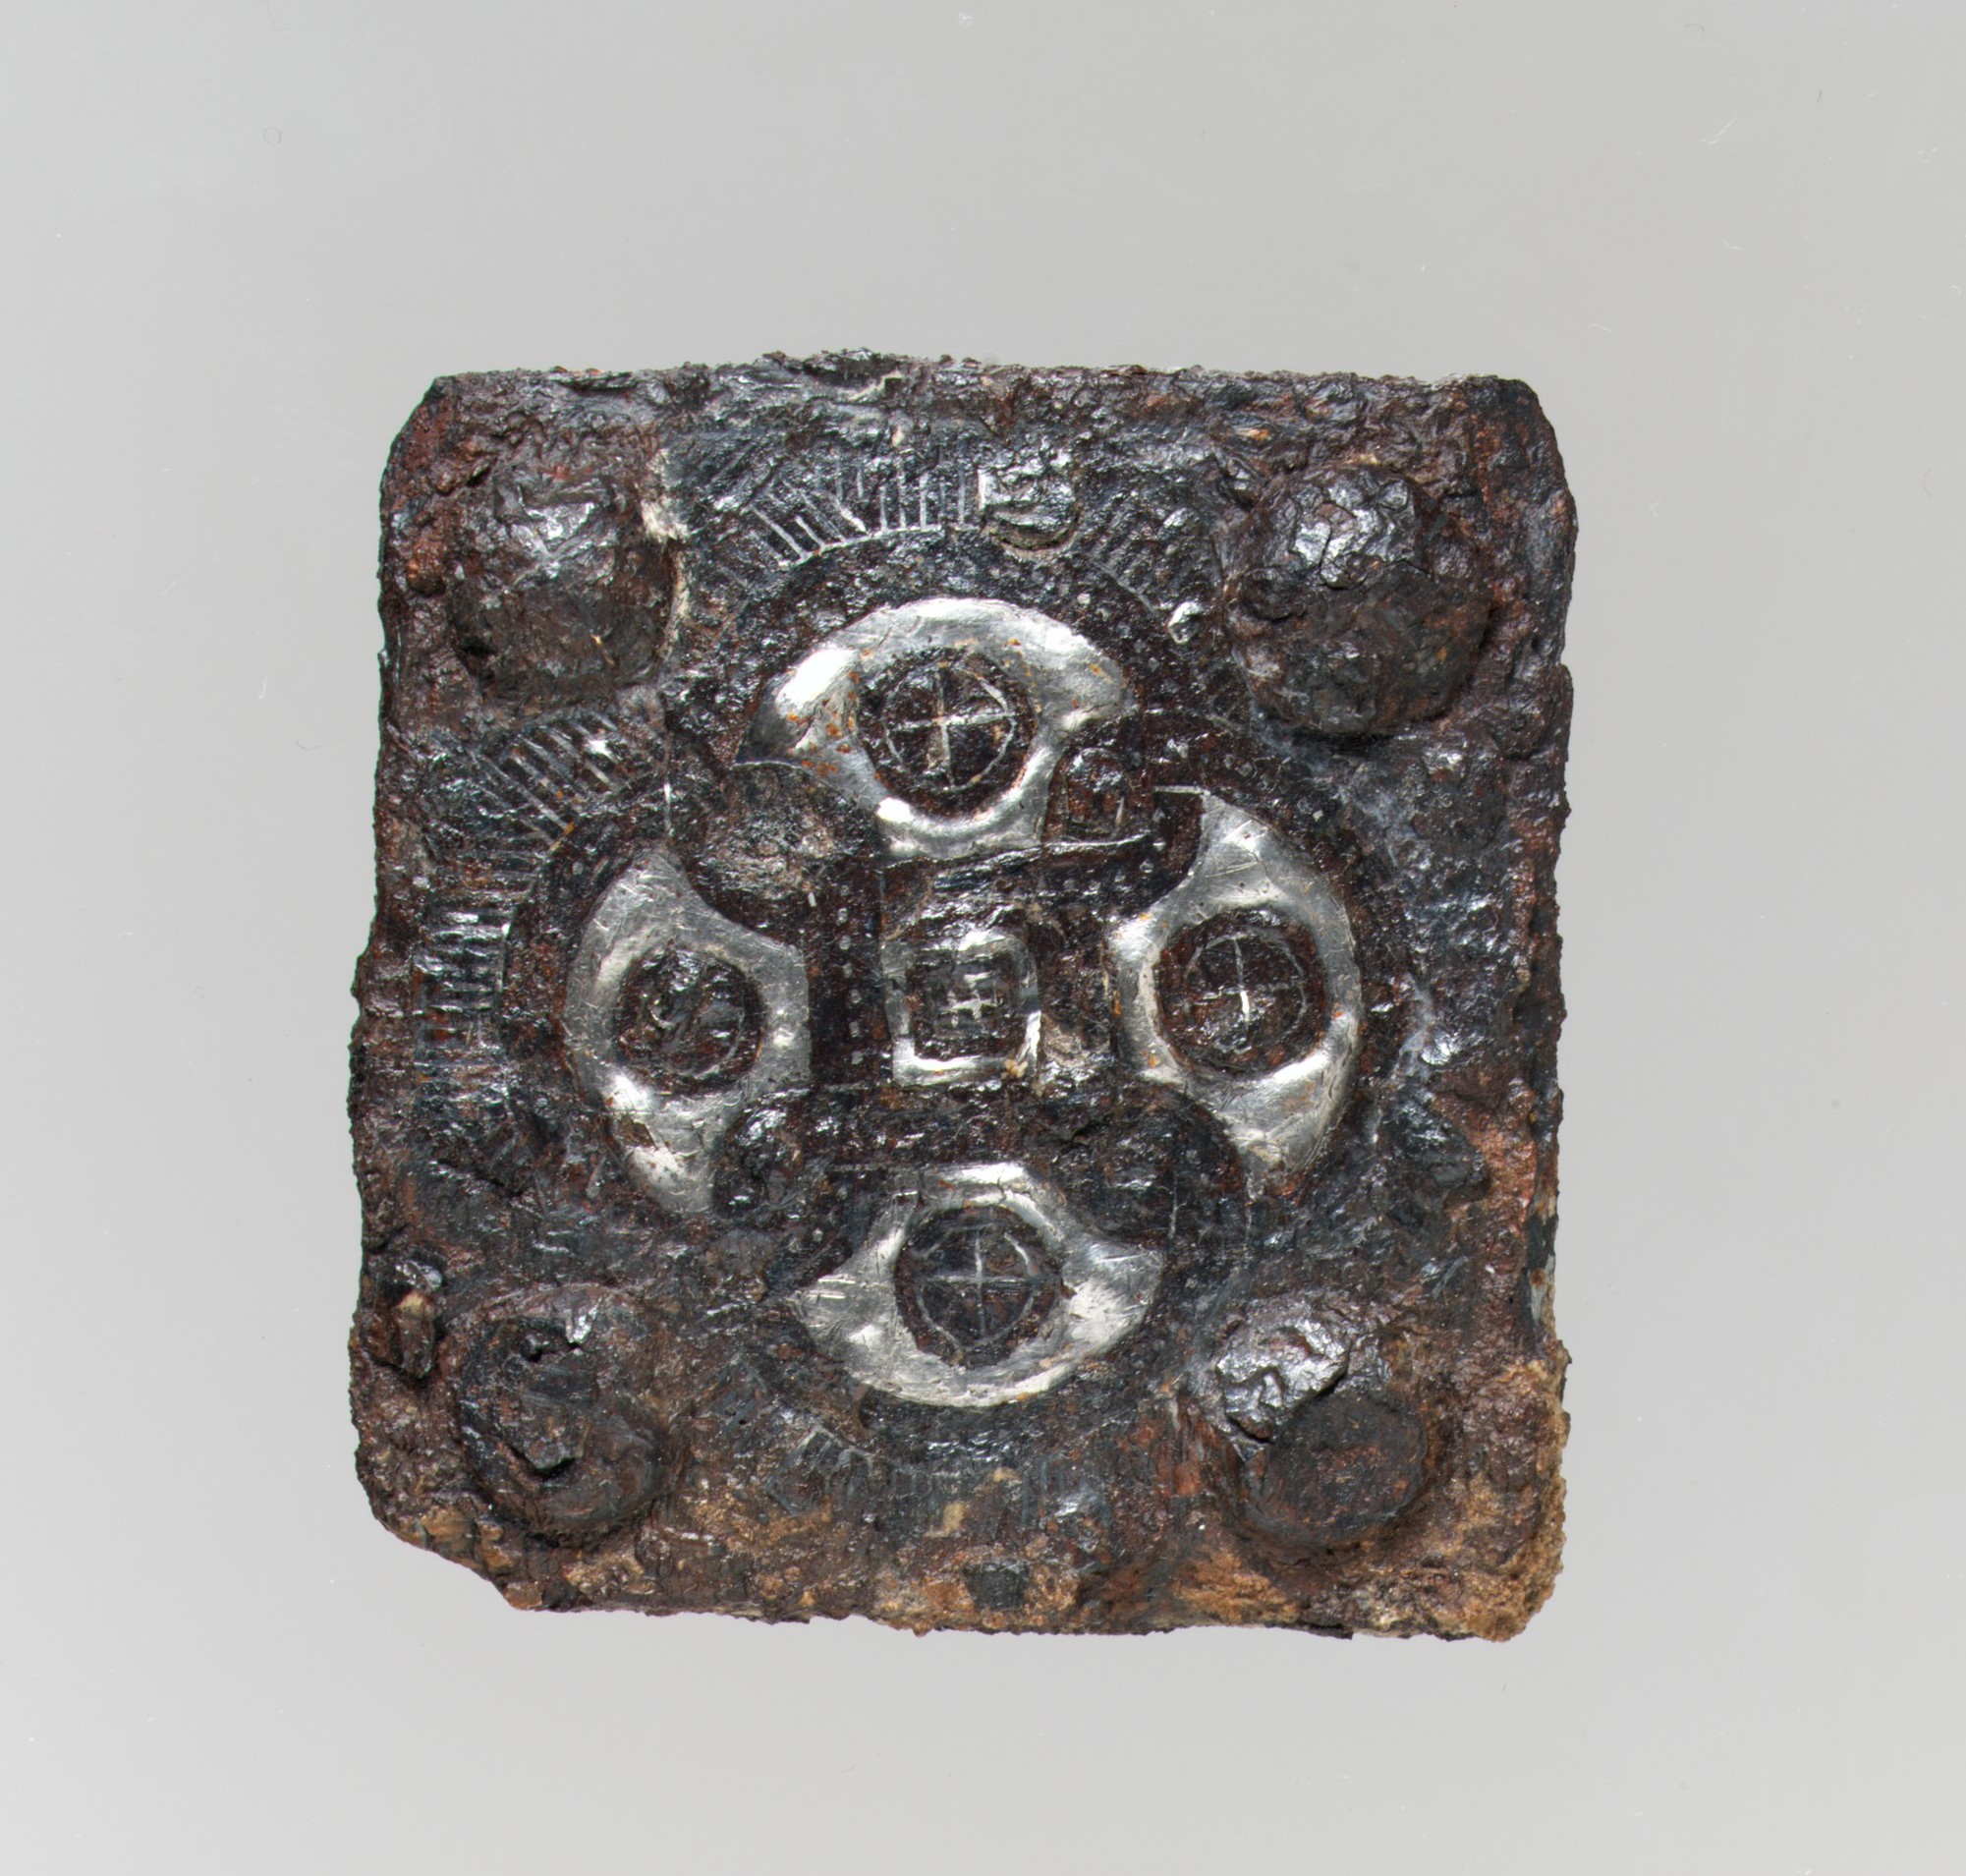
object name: belt plate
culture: burgundian or frankish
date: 601-700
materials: iron, silver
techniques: inlay